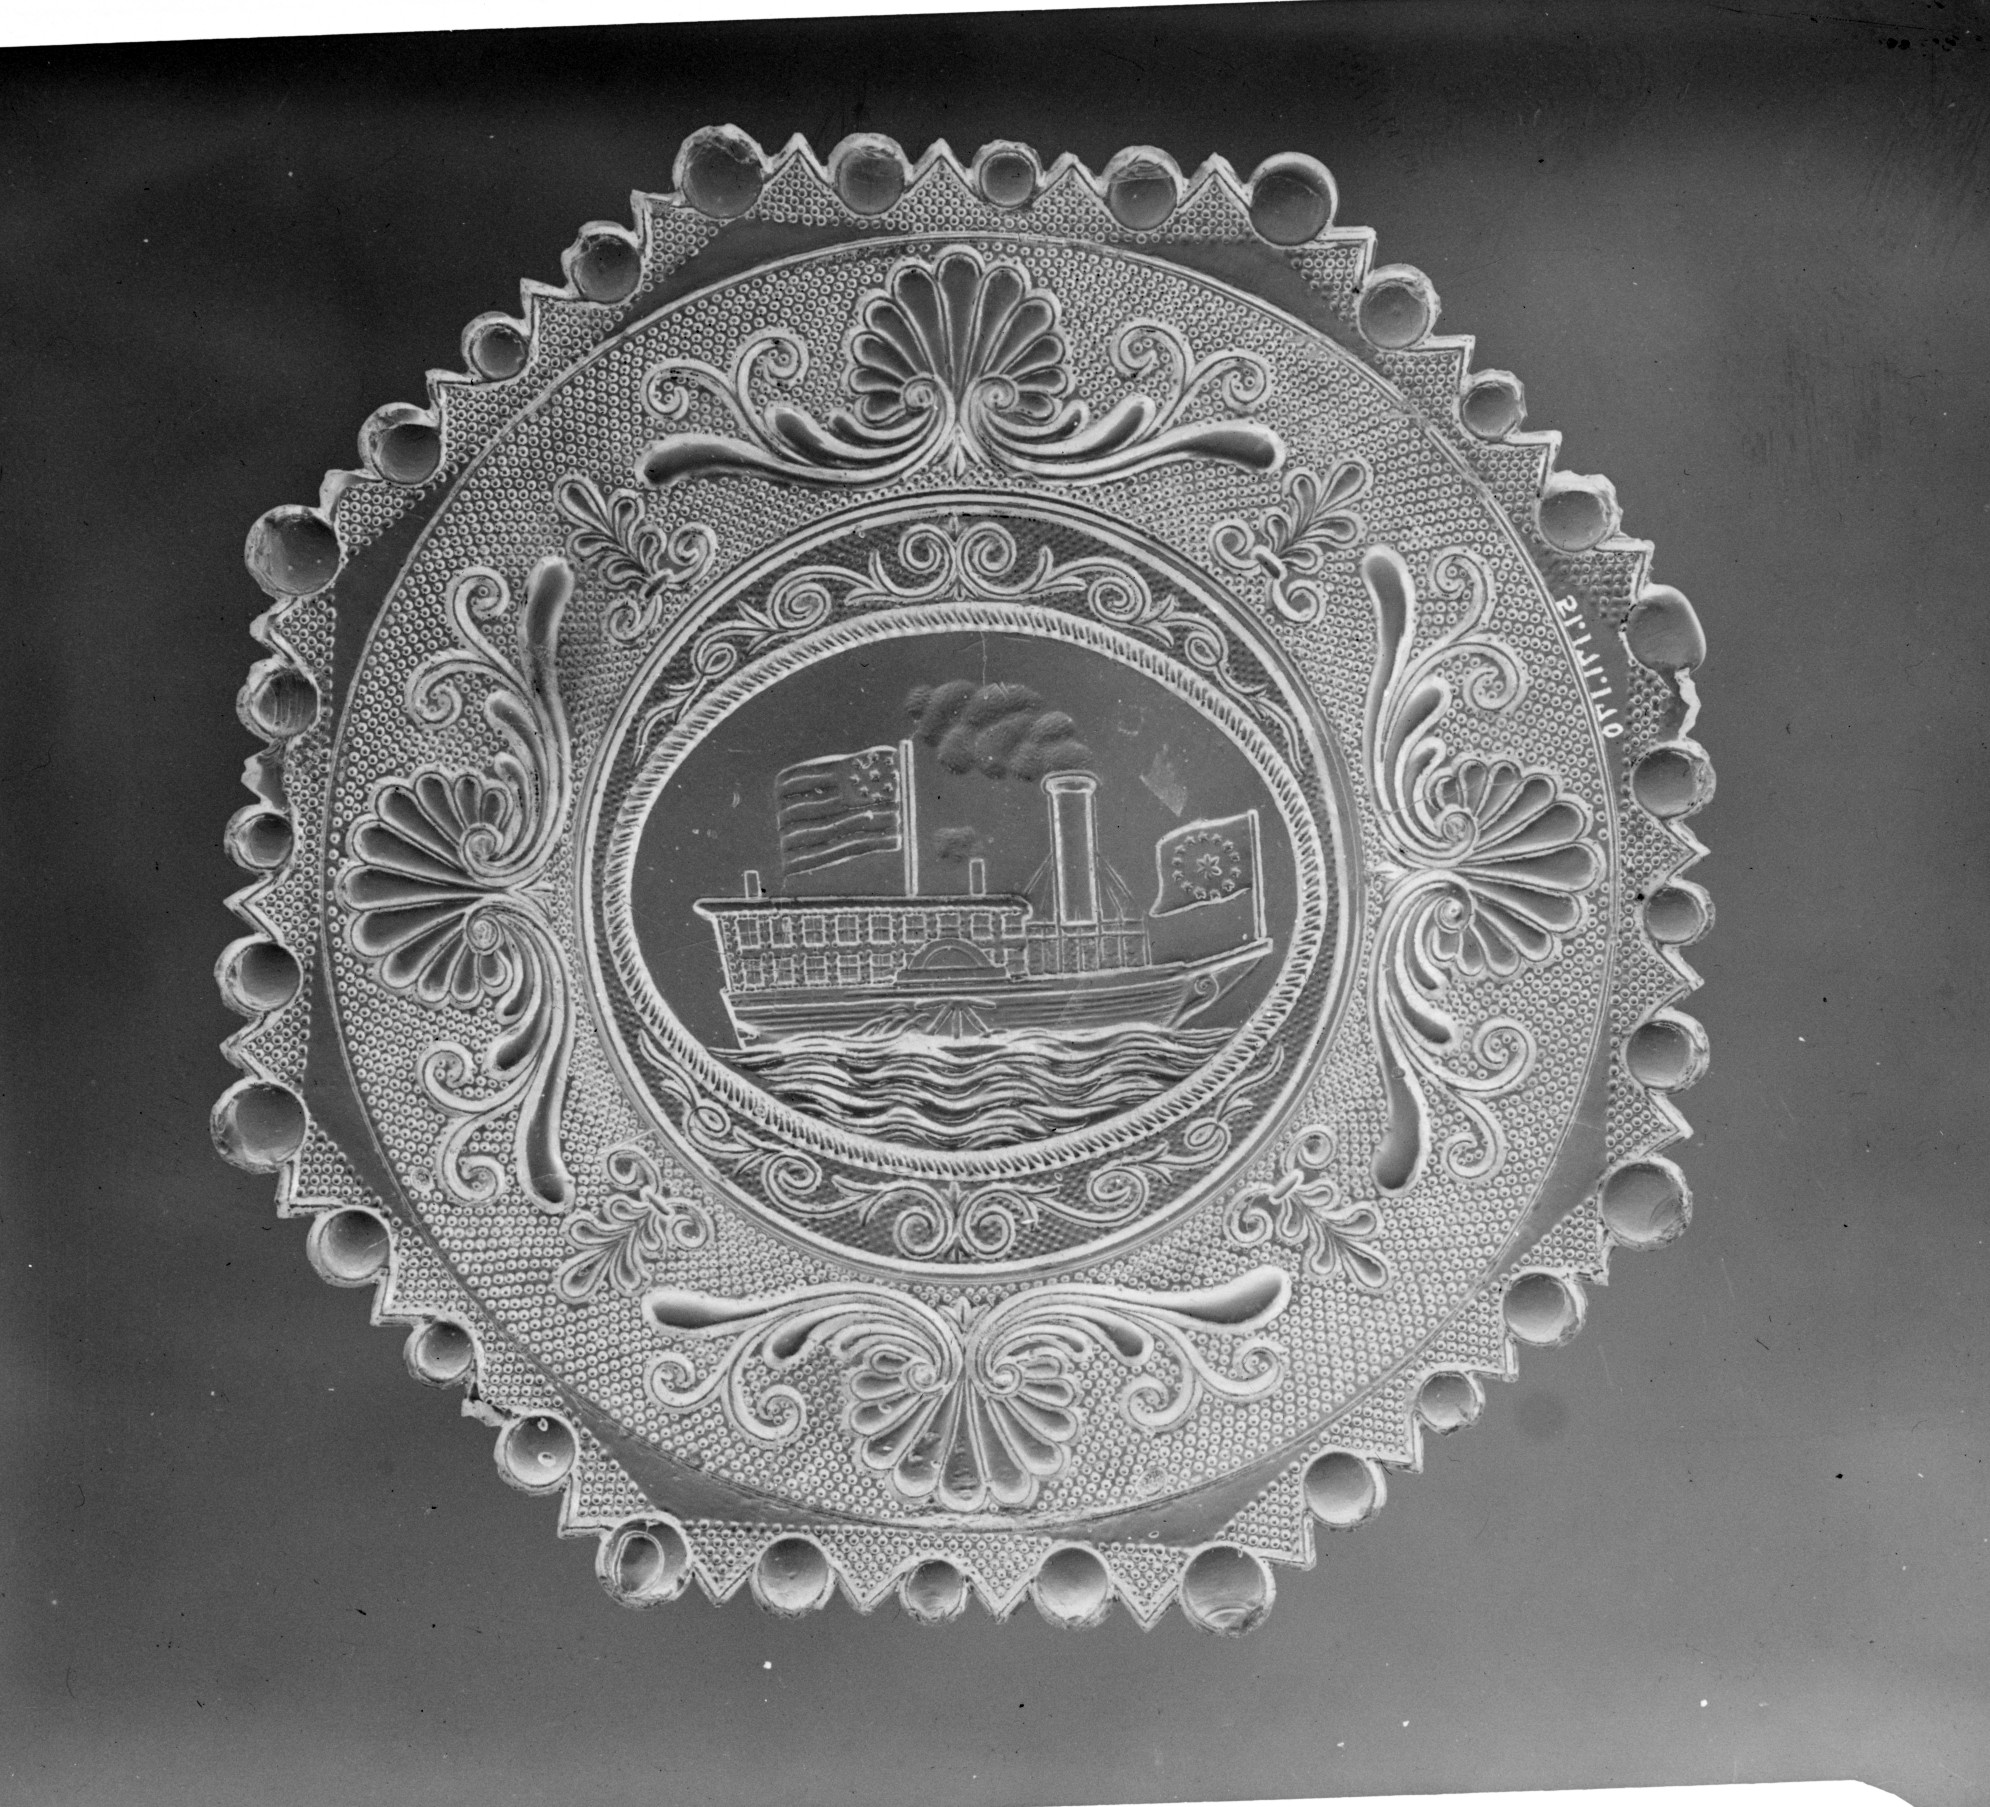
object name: plate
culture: american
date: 1830-1835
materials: glass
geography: united states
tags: ships